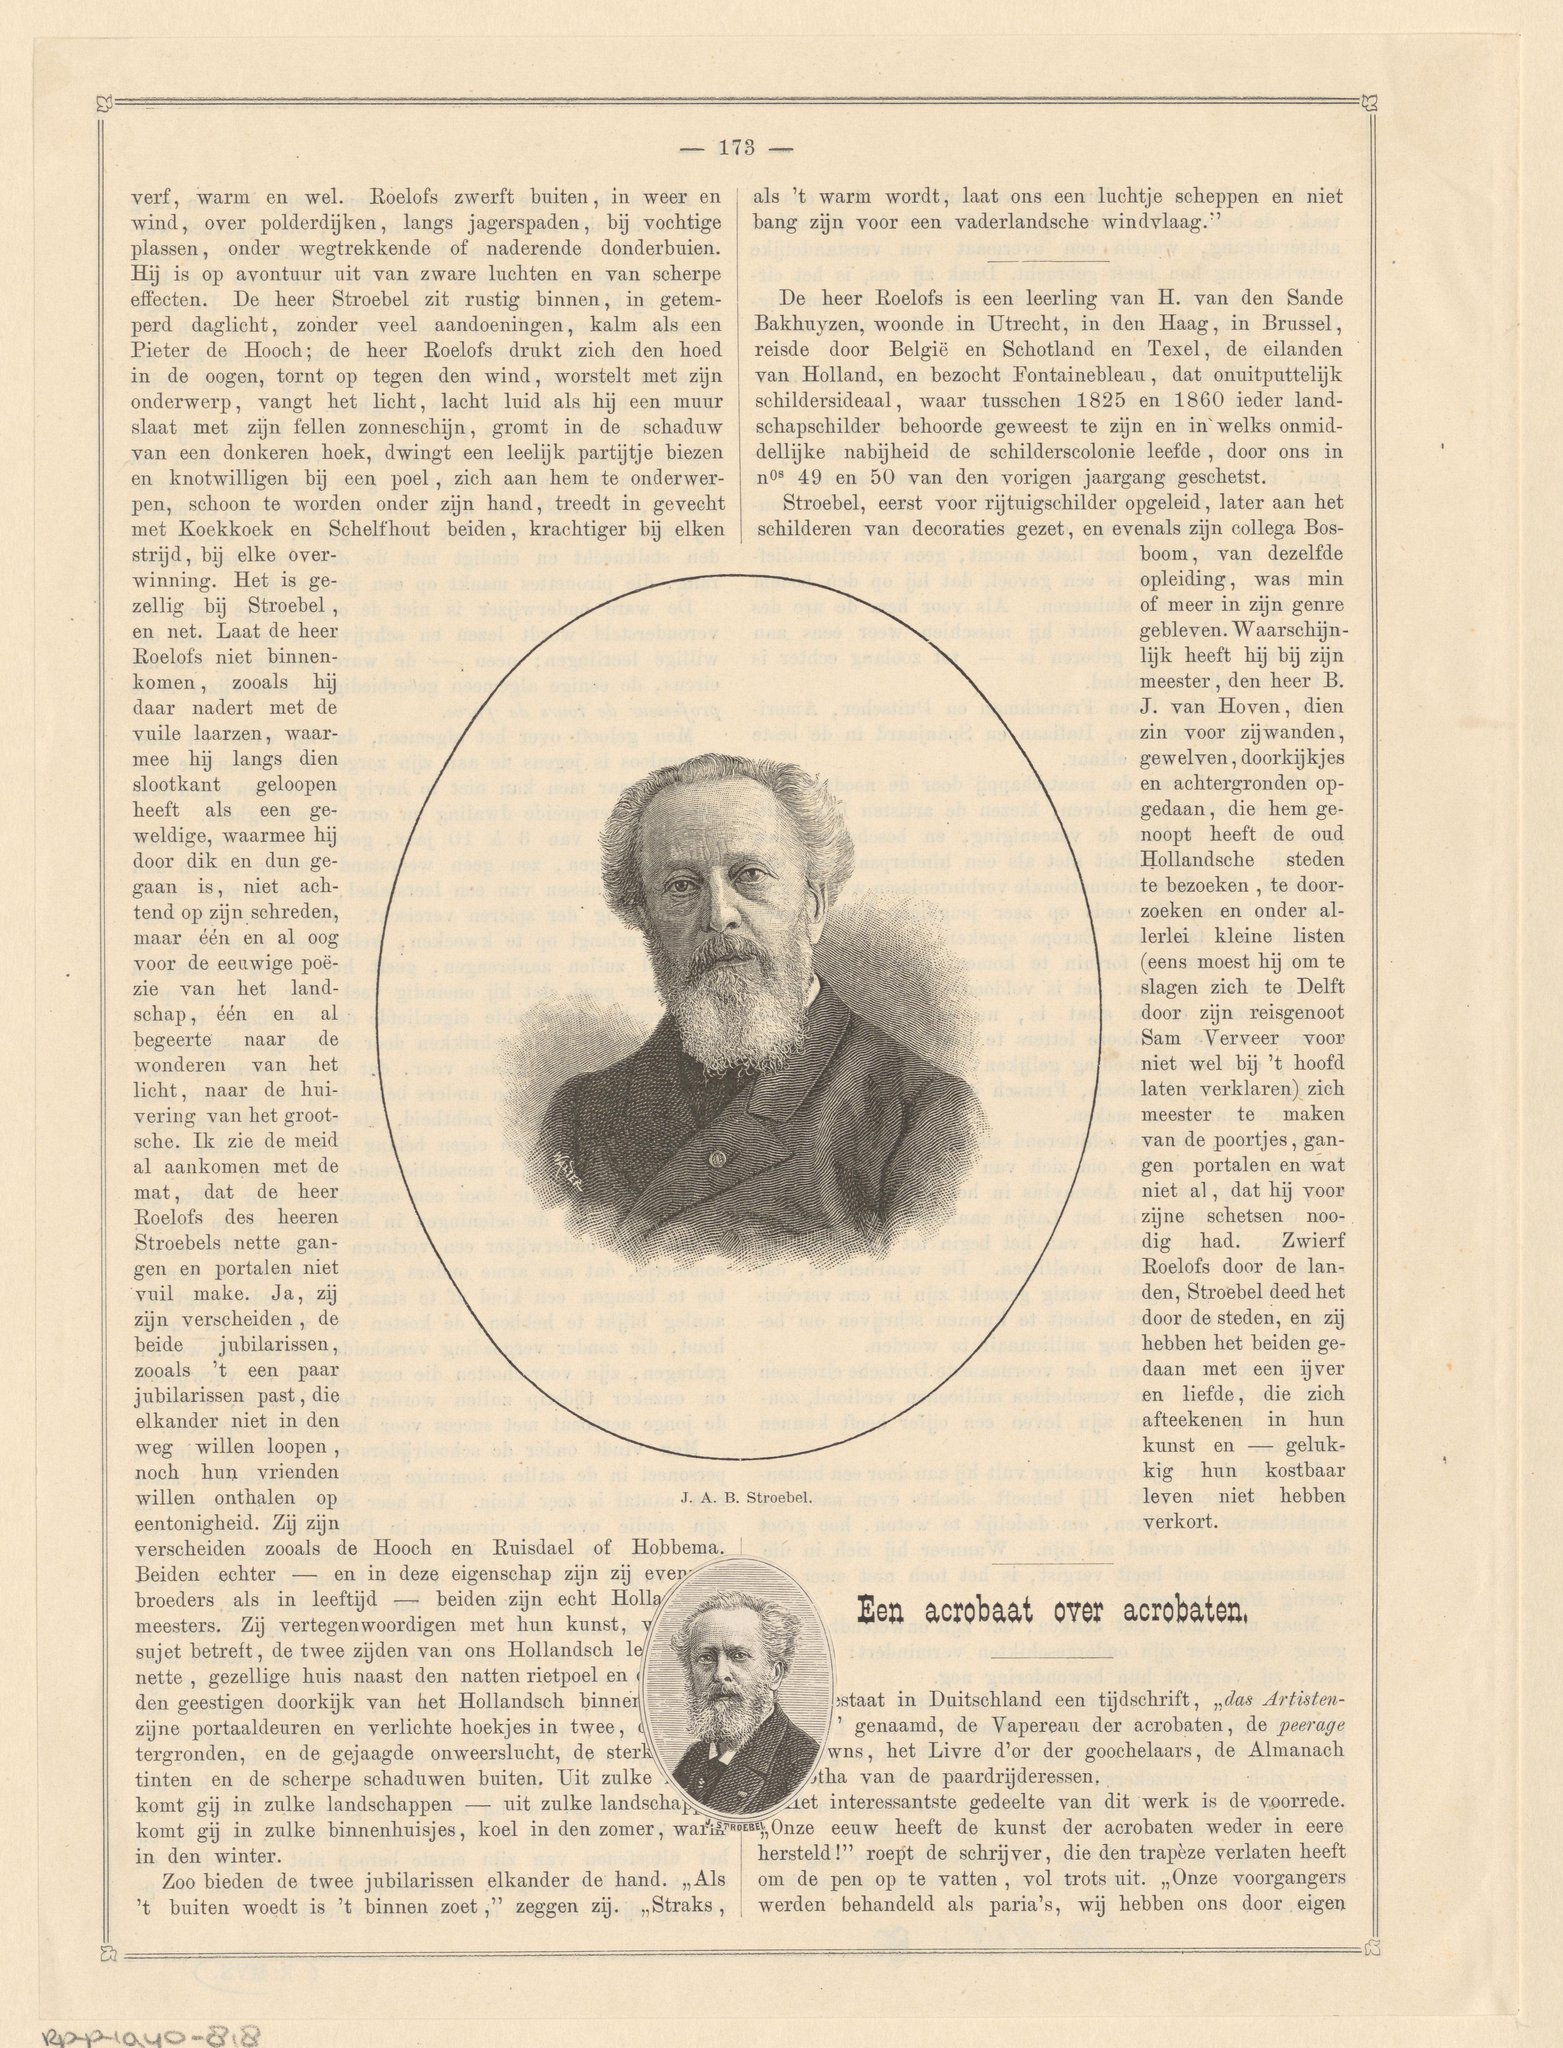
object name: print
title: Portret van Johannes Stroebel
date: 1880-1900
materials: paper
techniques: letterpress printing, engraving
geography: netherlands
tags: the hague, leiden, painter, print maker, draughtsman, johannes stroebel, historical persons, portrait, self-portrait of artist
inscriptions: collector's mark: Lugt 2760, collector's mark: Lugt 2228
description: Prent uit: Eigen Haard 11 (1892), p. 173. Onder het portret is een tweede portret geplakt van een anonieme prentmaker, gedateerd tussen 1880-1900.